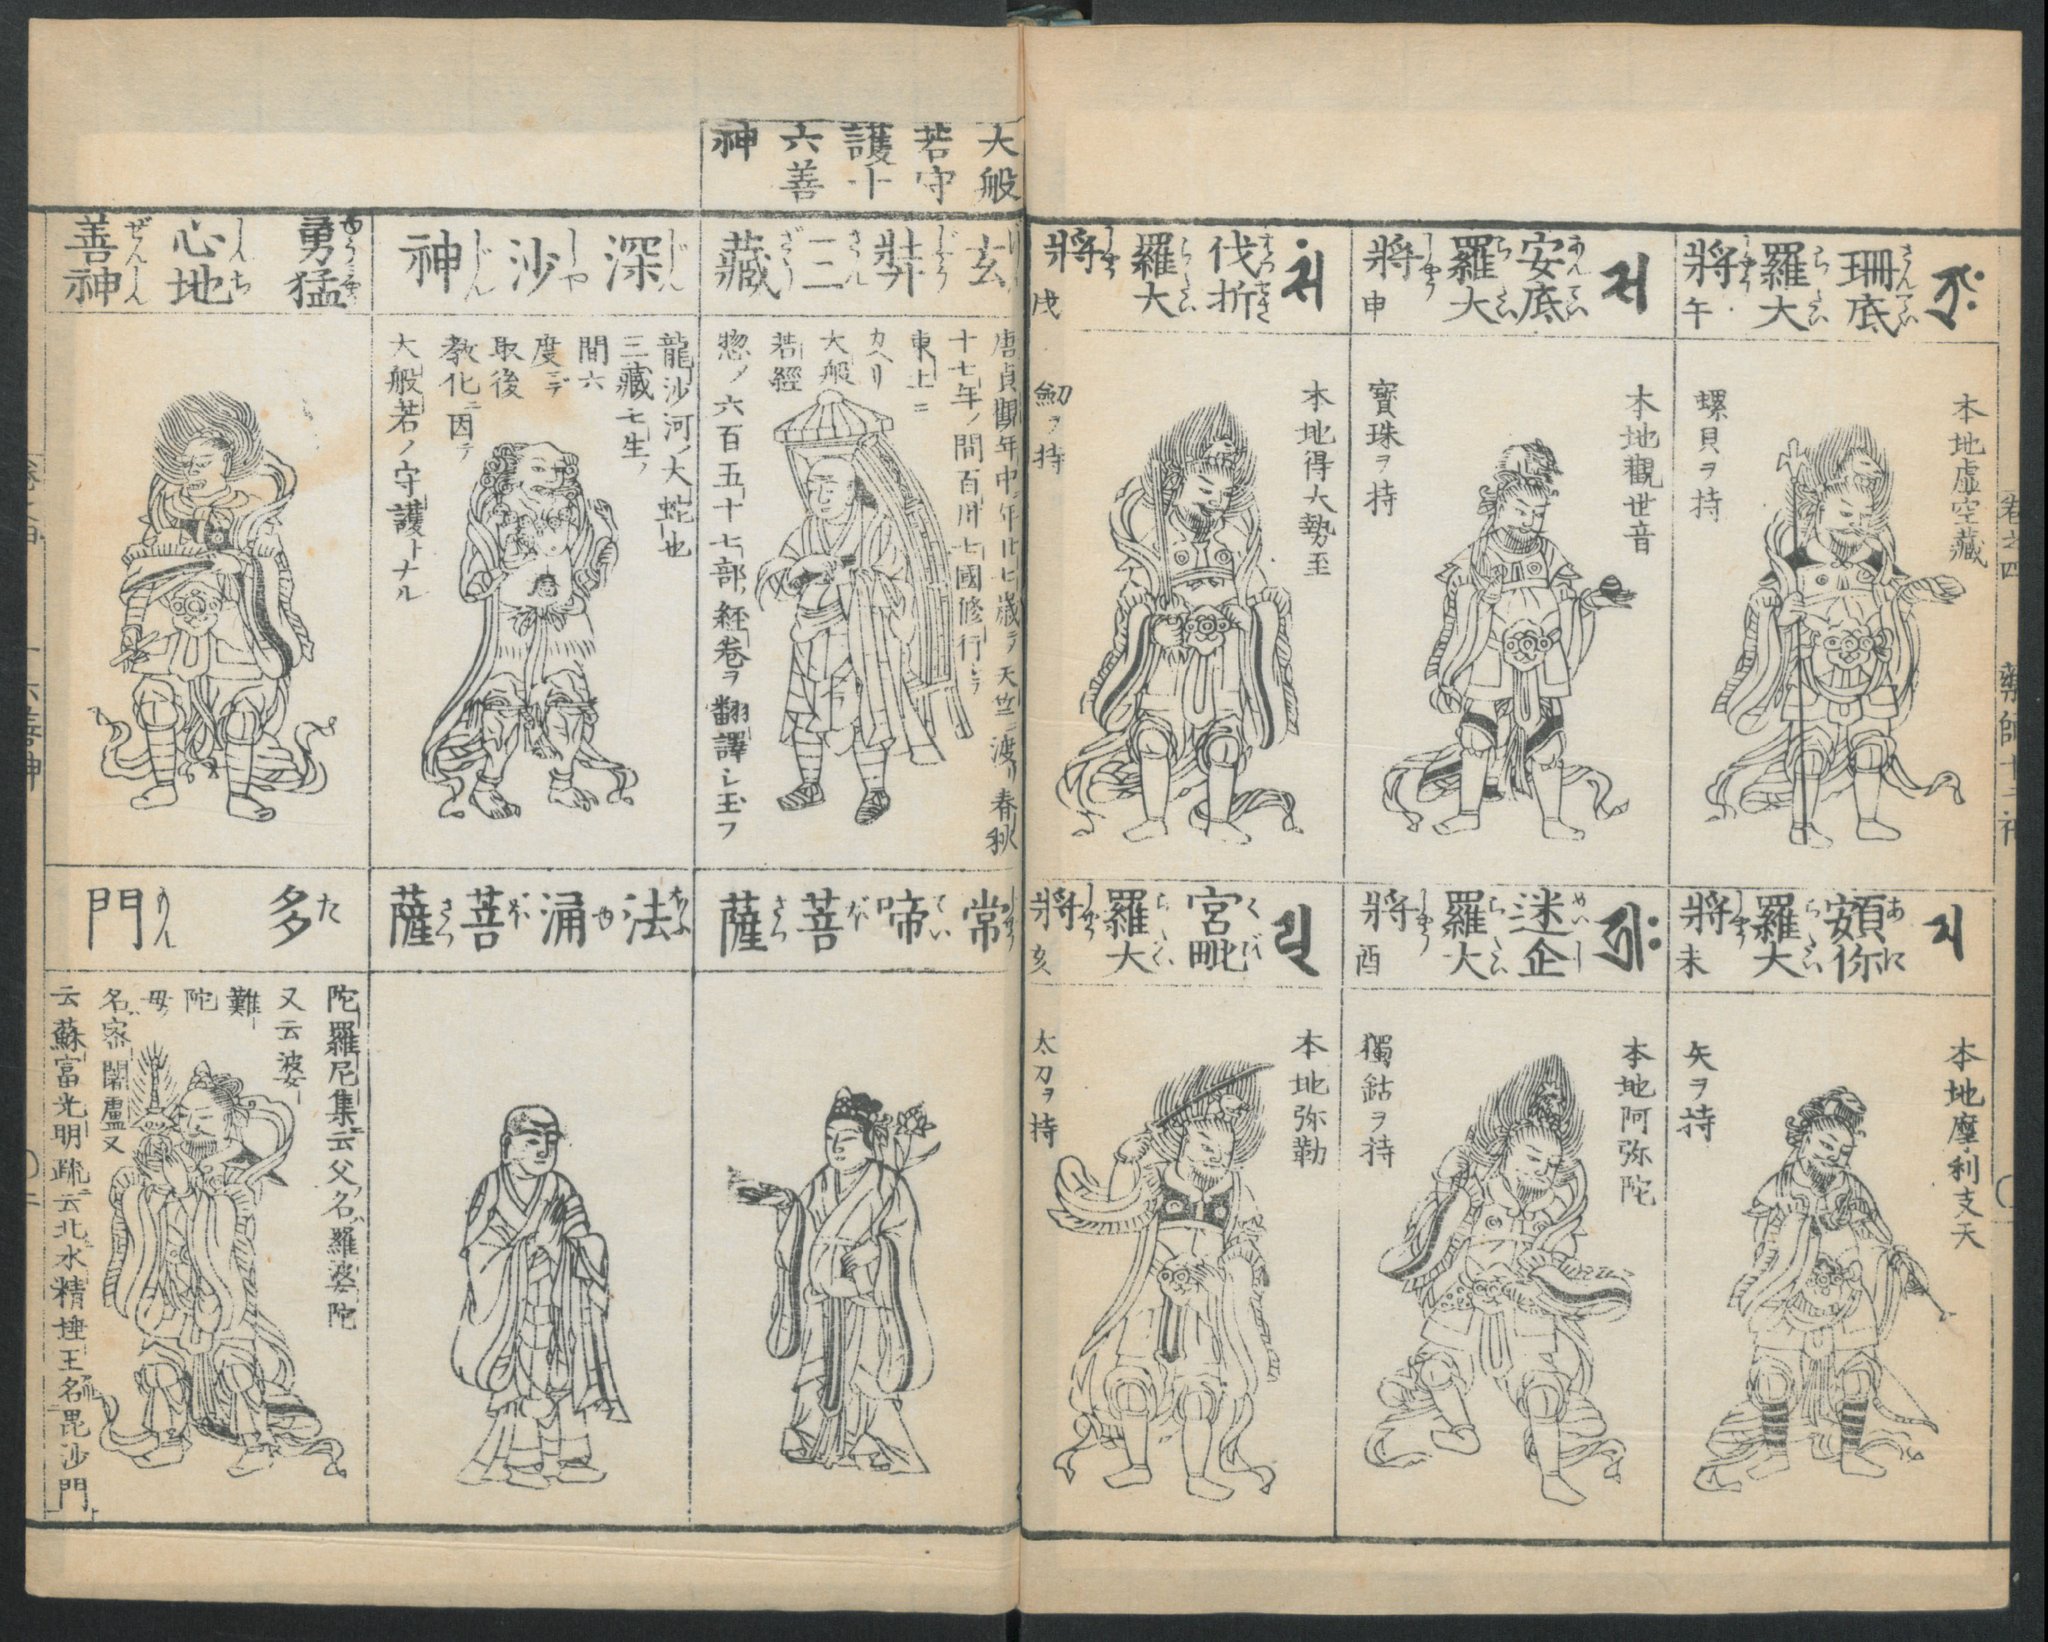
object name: illustrated book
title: Buddhist Figures and Their Attributes (Zōho shoshū Butsuzō zui) 増補諸宗 佛像図彙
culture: japanese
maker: kino shūshin 紀秀信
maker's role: artist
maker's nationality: japanese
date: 1801-1900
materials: ink, paper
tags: men,women,buddhism